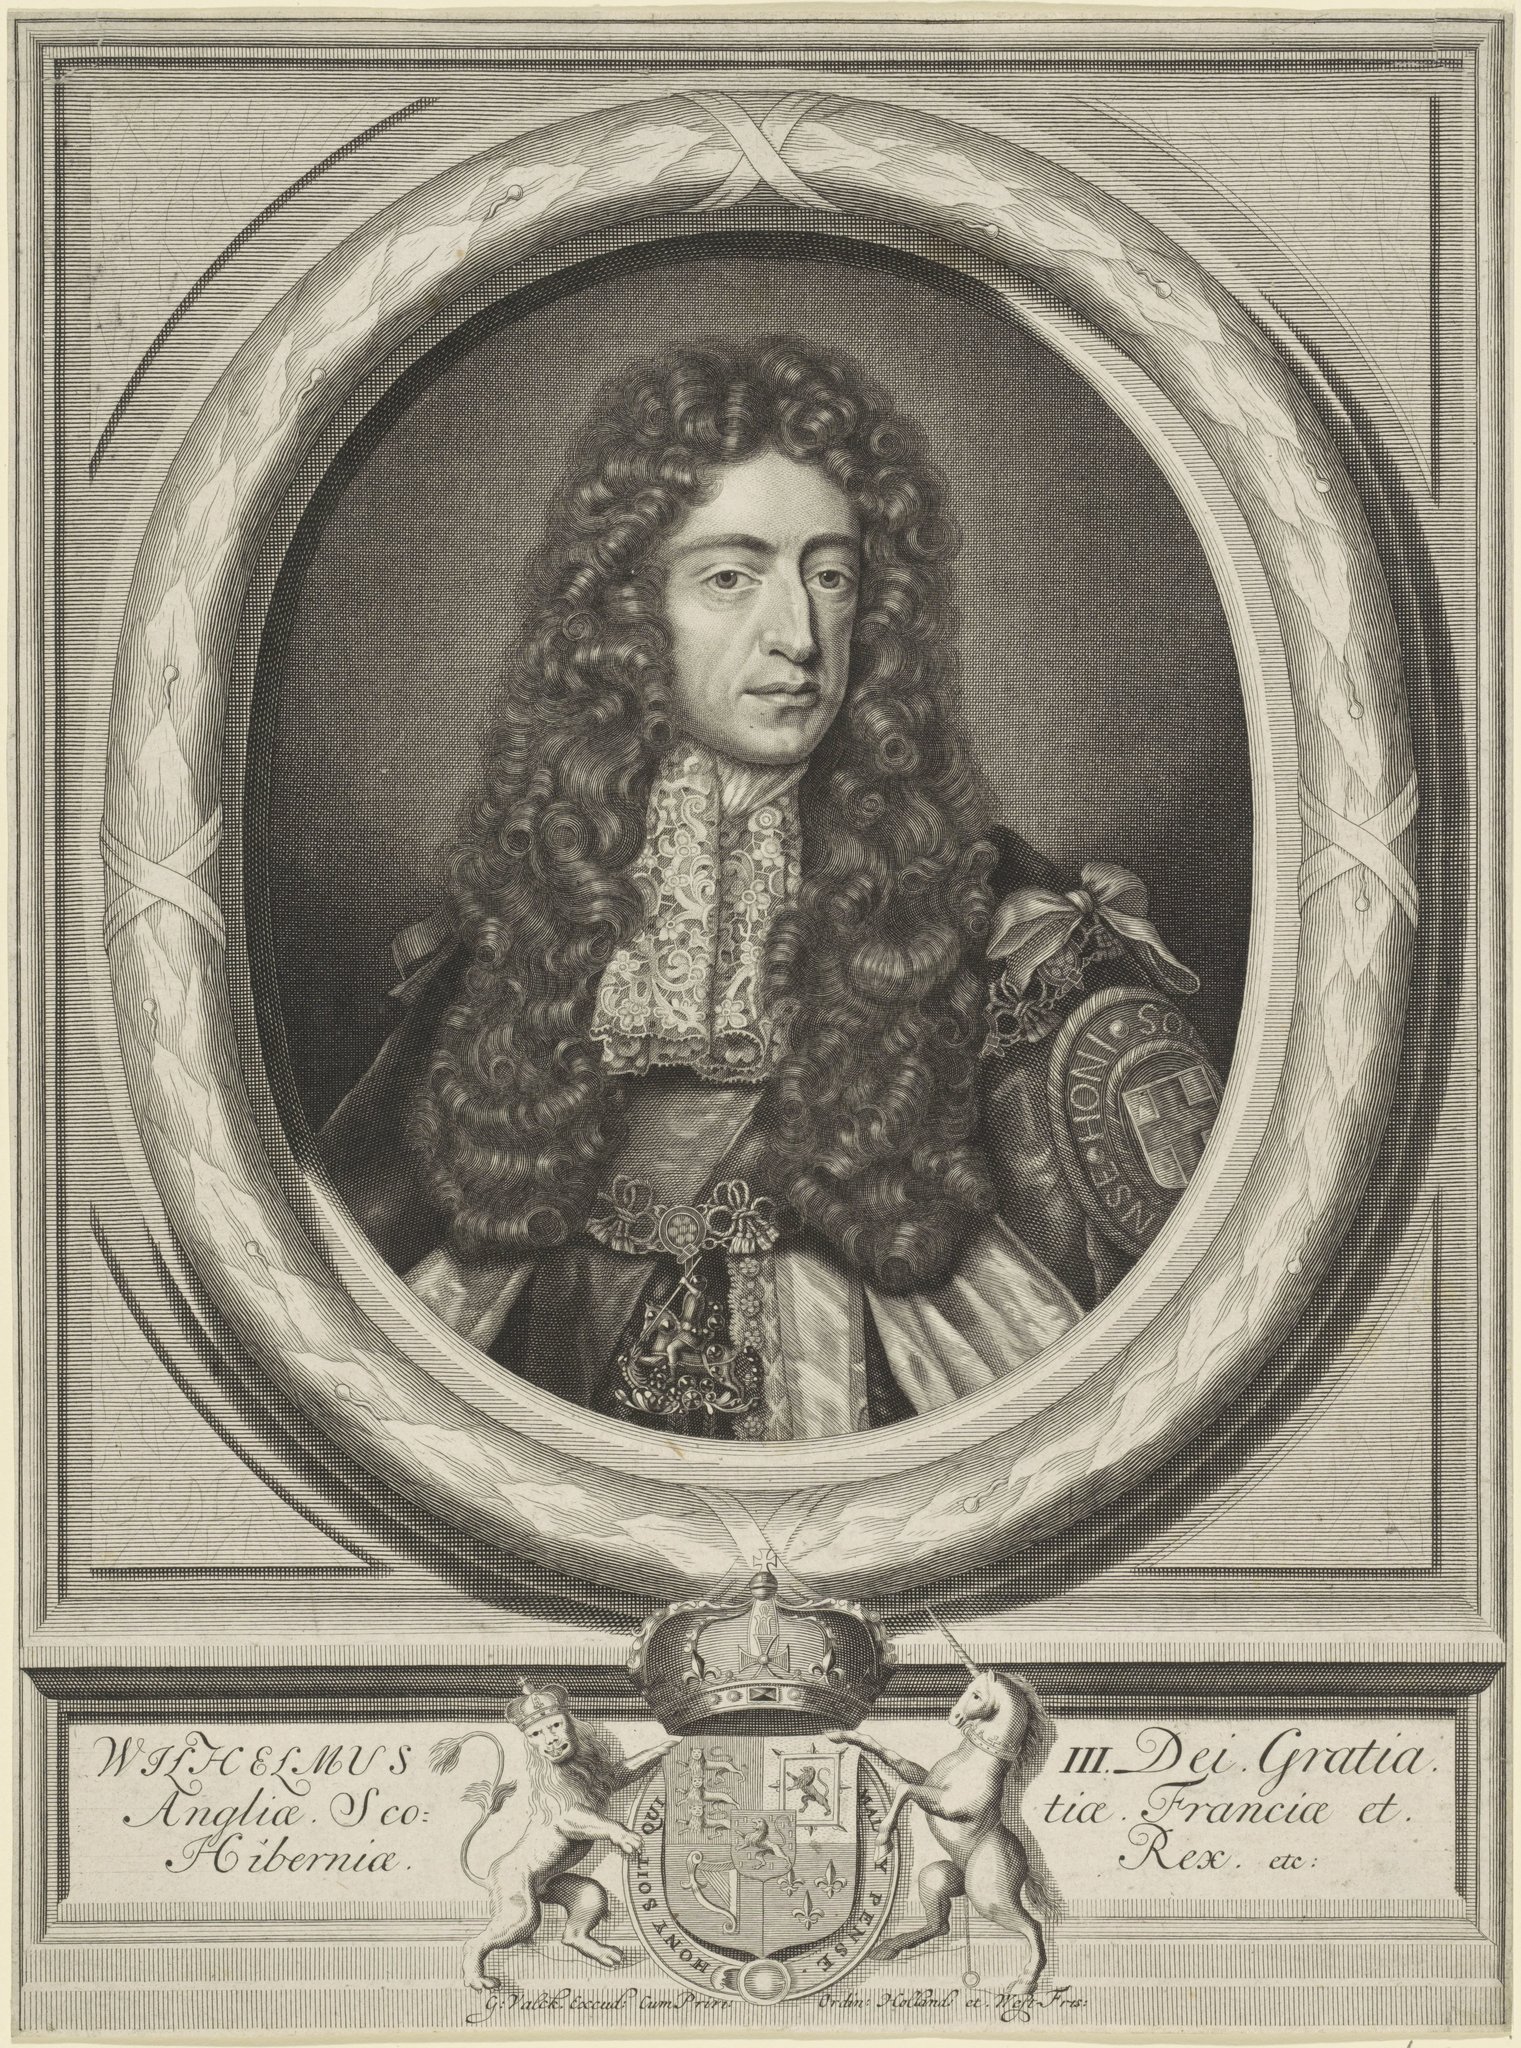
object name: print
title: Portret van Willem III, prins van Oranje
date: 1688-1726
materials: paper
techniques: engraving, etching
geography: low countries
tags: the hague, william iii (prince of orange and king of england, scotland, and ireland), knighthood order (garter) - insignia of a knighthood order, e.g.: badge, chain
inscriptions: collector's mark: Lugt 963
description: Portret van Willem III in een ovaal van eikenloof. Midden onder zijn wapen met een kroon, een leeuw en een eenhoorn, gedecoreerd met de Kousenband en het devies van de Orde van de Kousenband. Op een voetstuk zijn naam en titels.